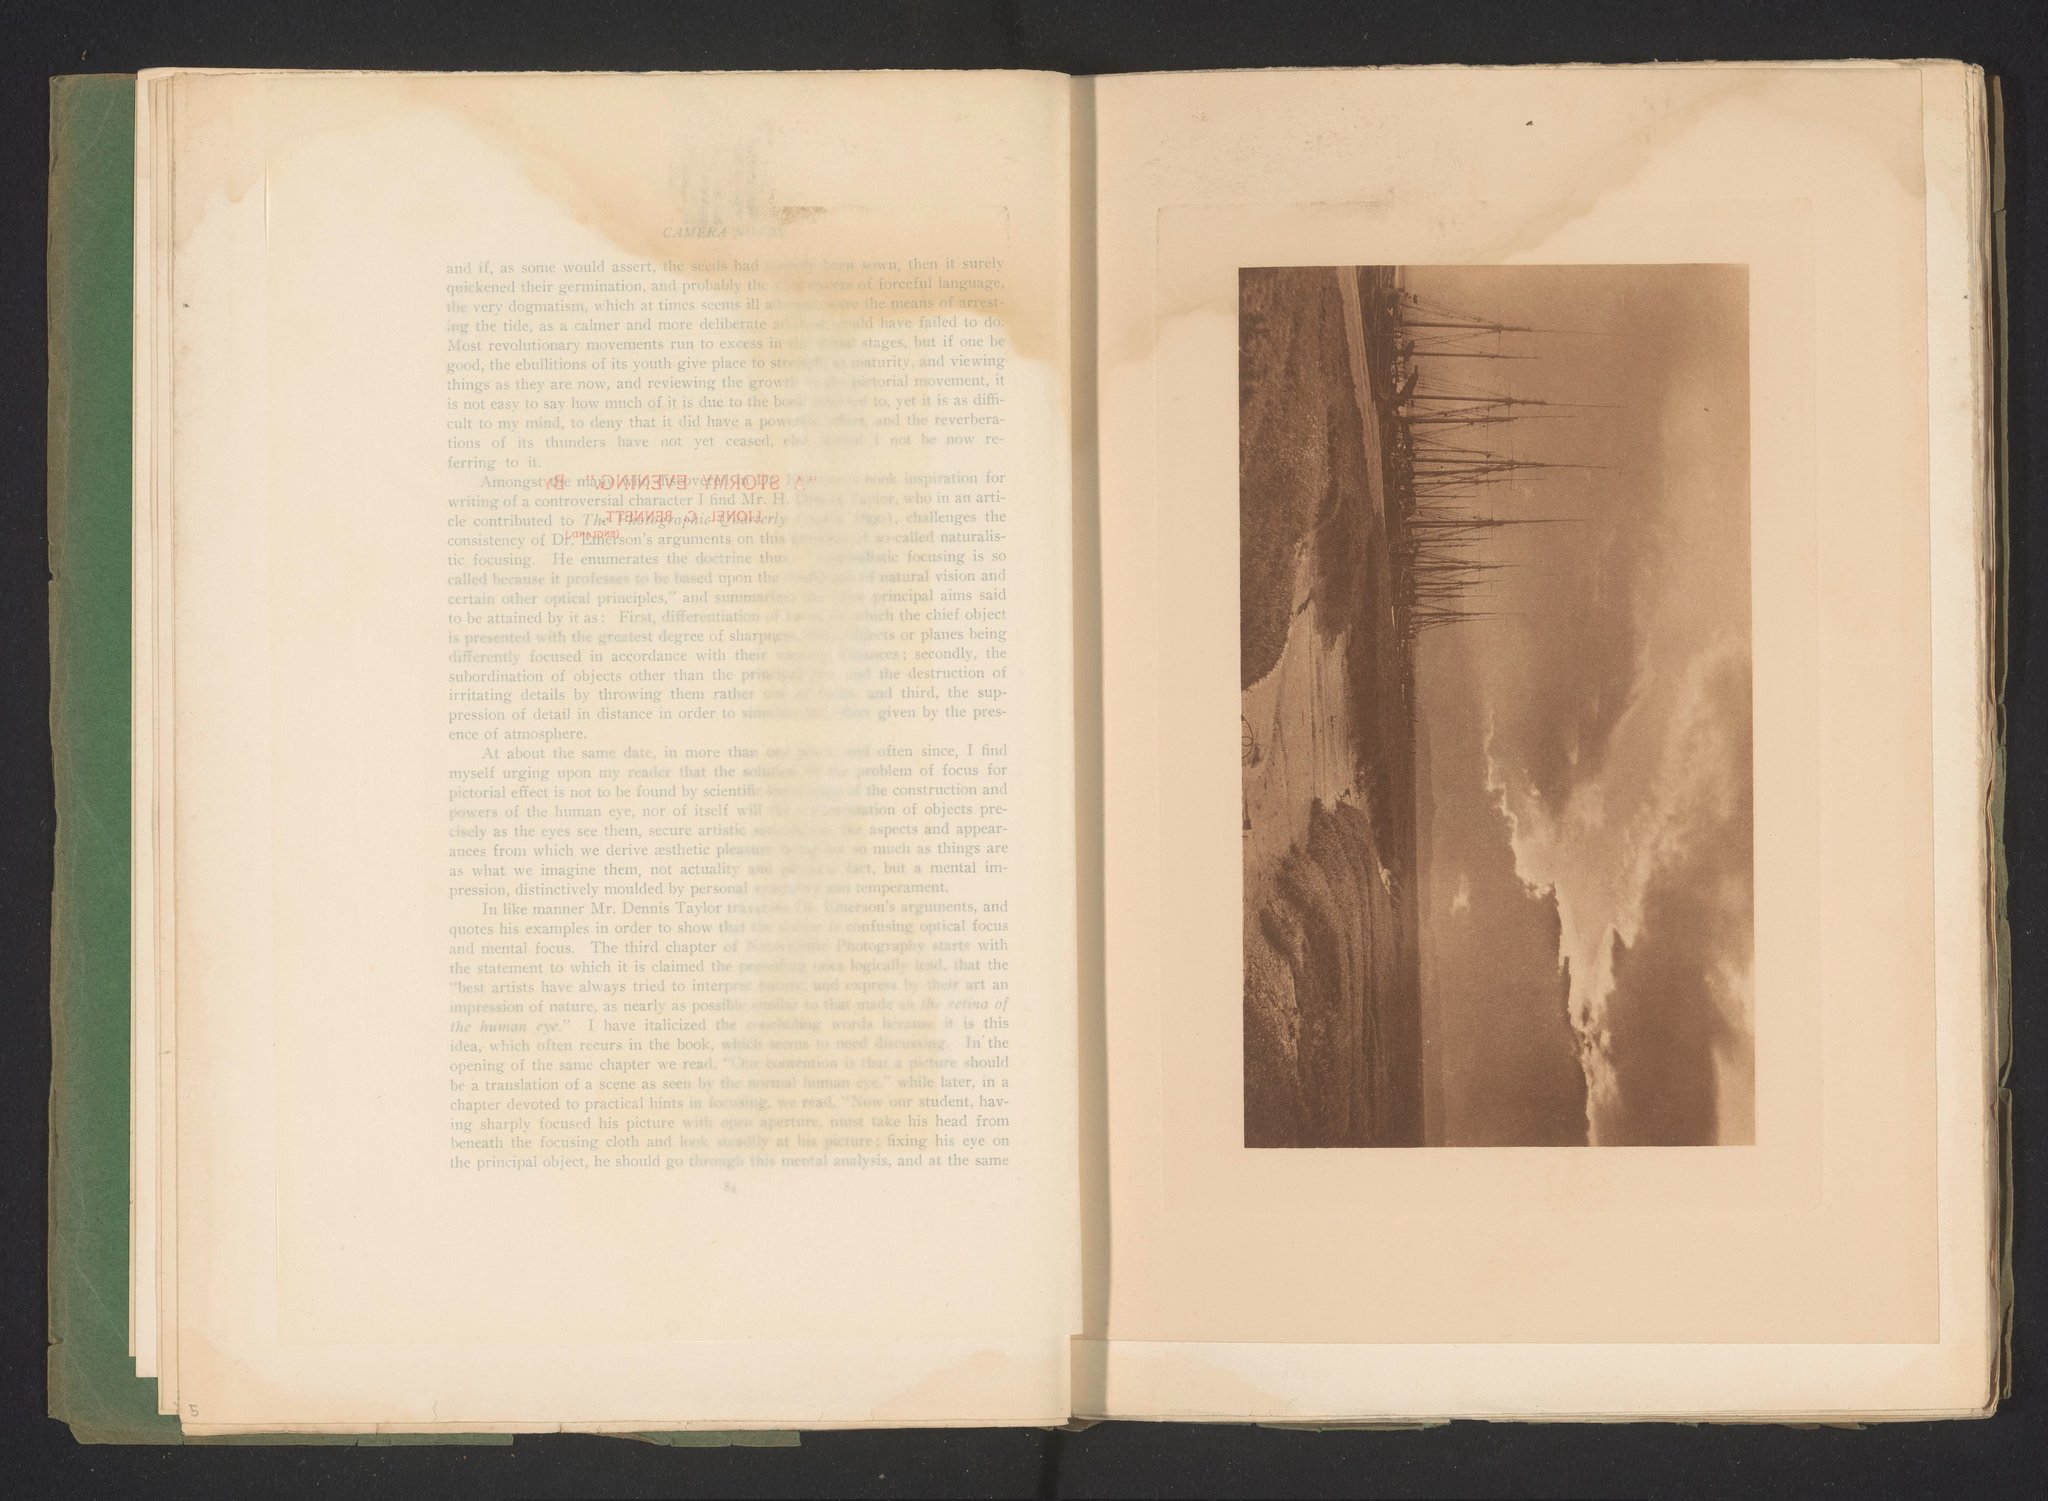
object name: page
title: A Stormy Evening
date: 1895-1900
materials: paper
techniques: photoaquatint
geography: new york city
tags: harbour, landscapes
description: Prent tegenover pagina 84, achter semi-transparante omslag.